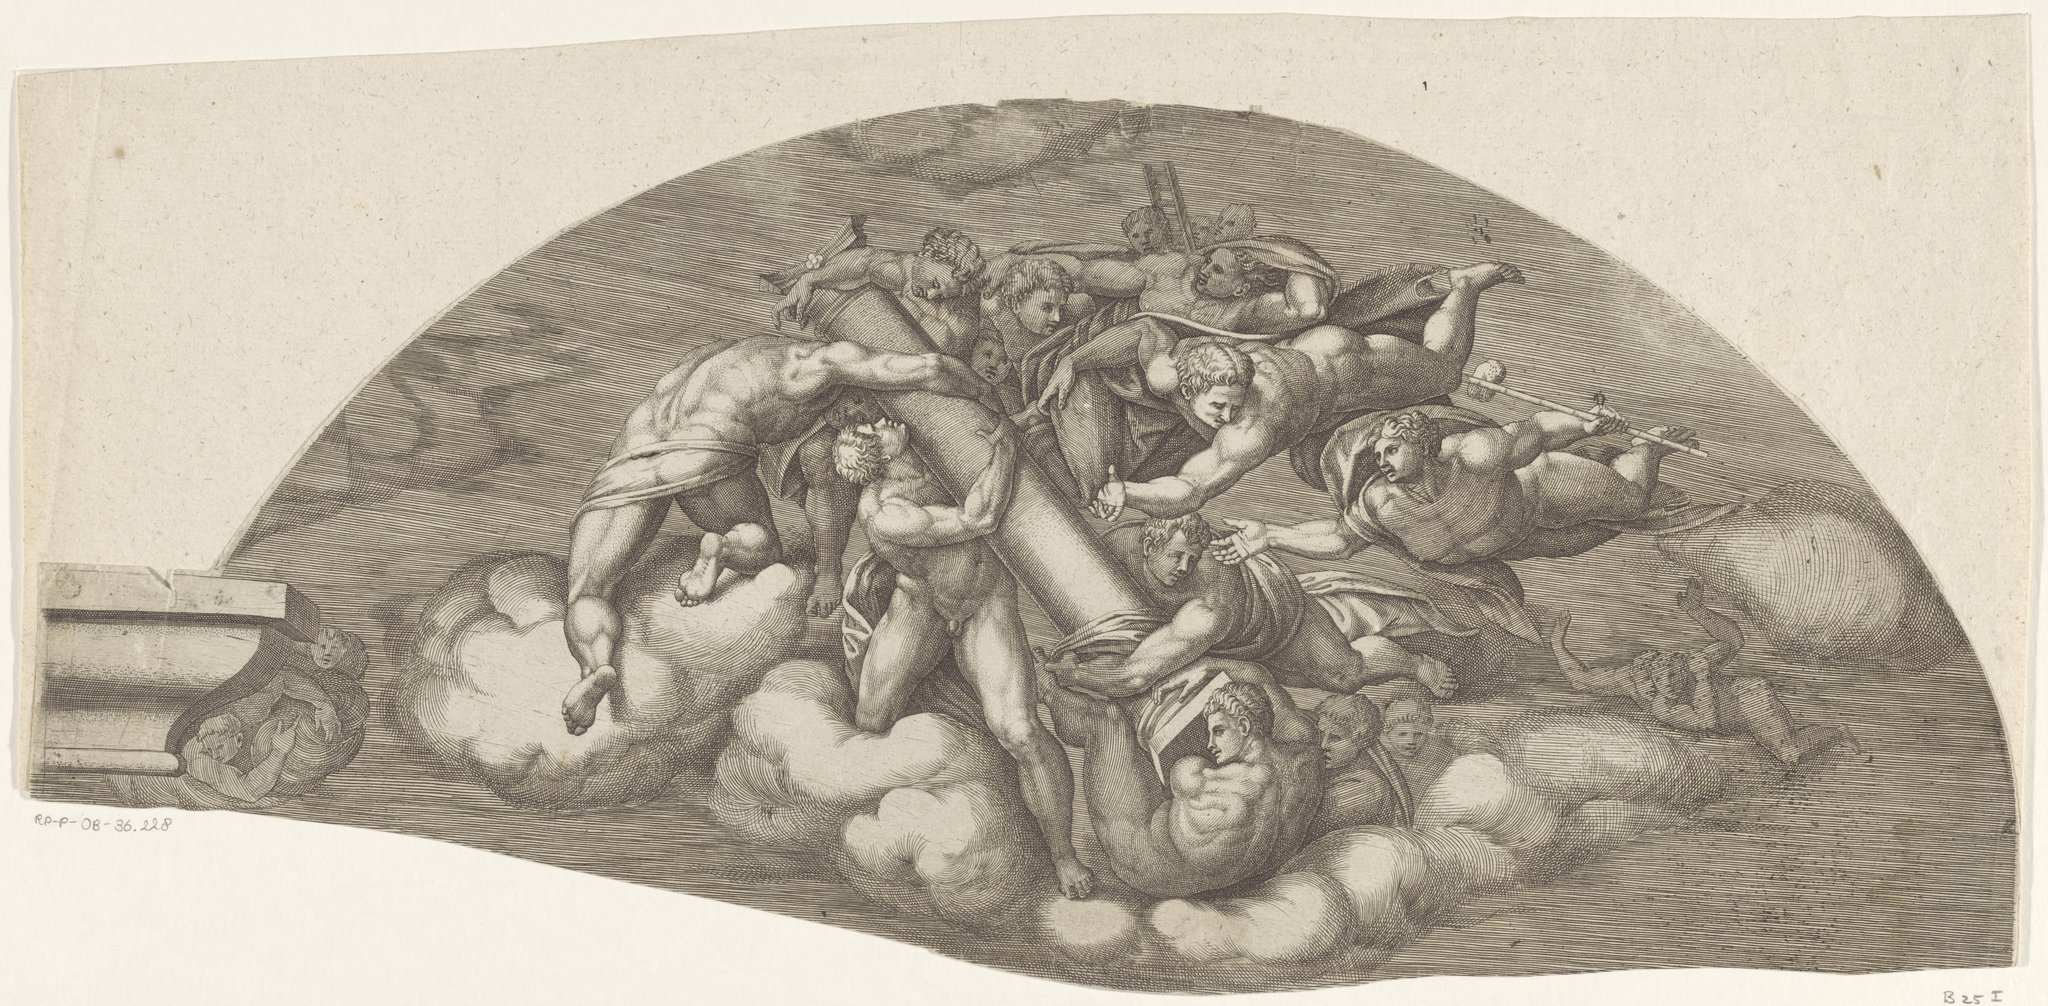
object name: print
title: Het laatste oordeel, blad A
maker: giorgio ghisi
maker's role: print maker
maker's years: 1520-1582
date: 1530-1582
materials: paper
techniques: engraving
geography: italy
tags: last judgement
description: Prent maakt deel uit van een groep van tien prenten die samen één grote voorstelling vormen naar het fresco met het Laatste Oordeel door Michelangelo in de Sixtijnse Kapel in het Vaticaan.